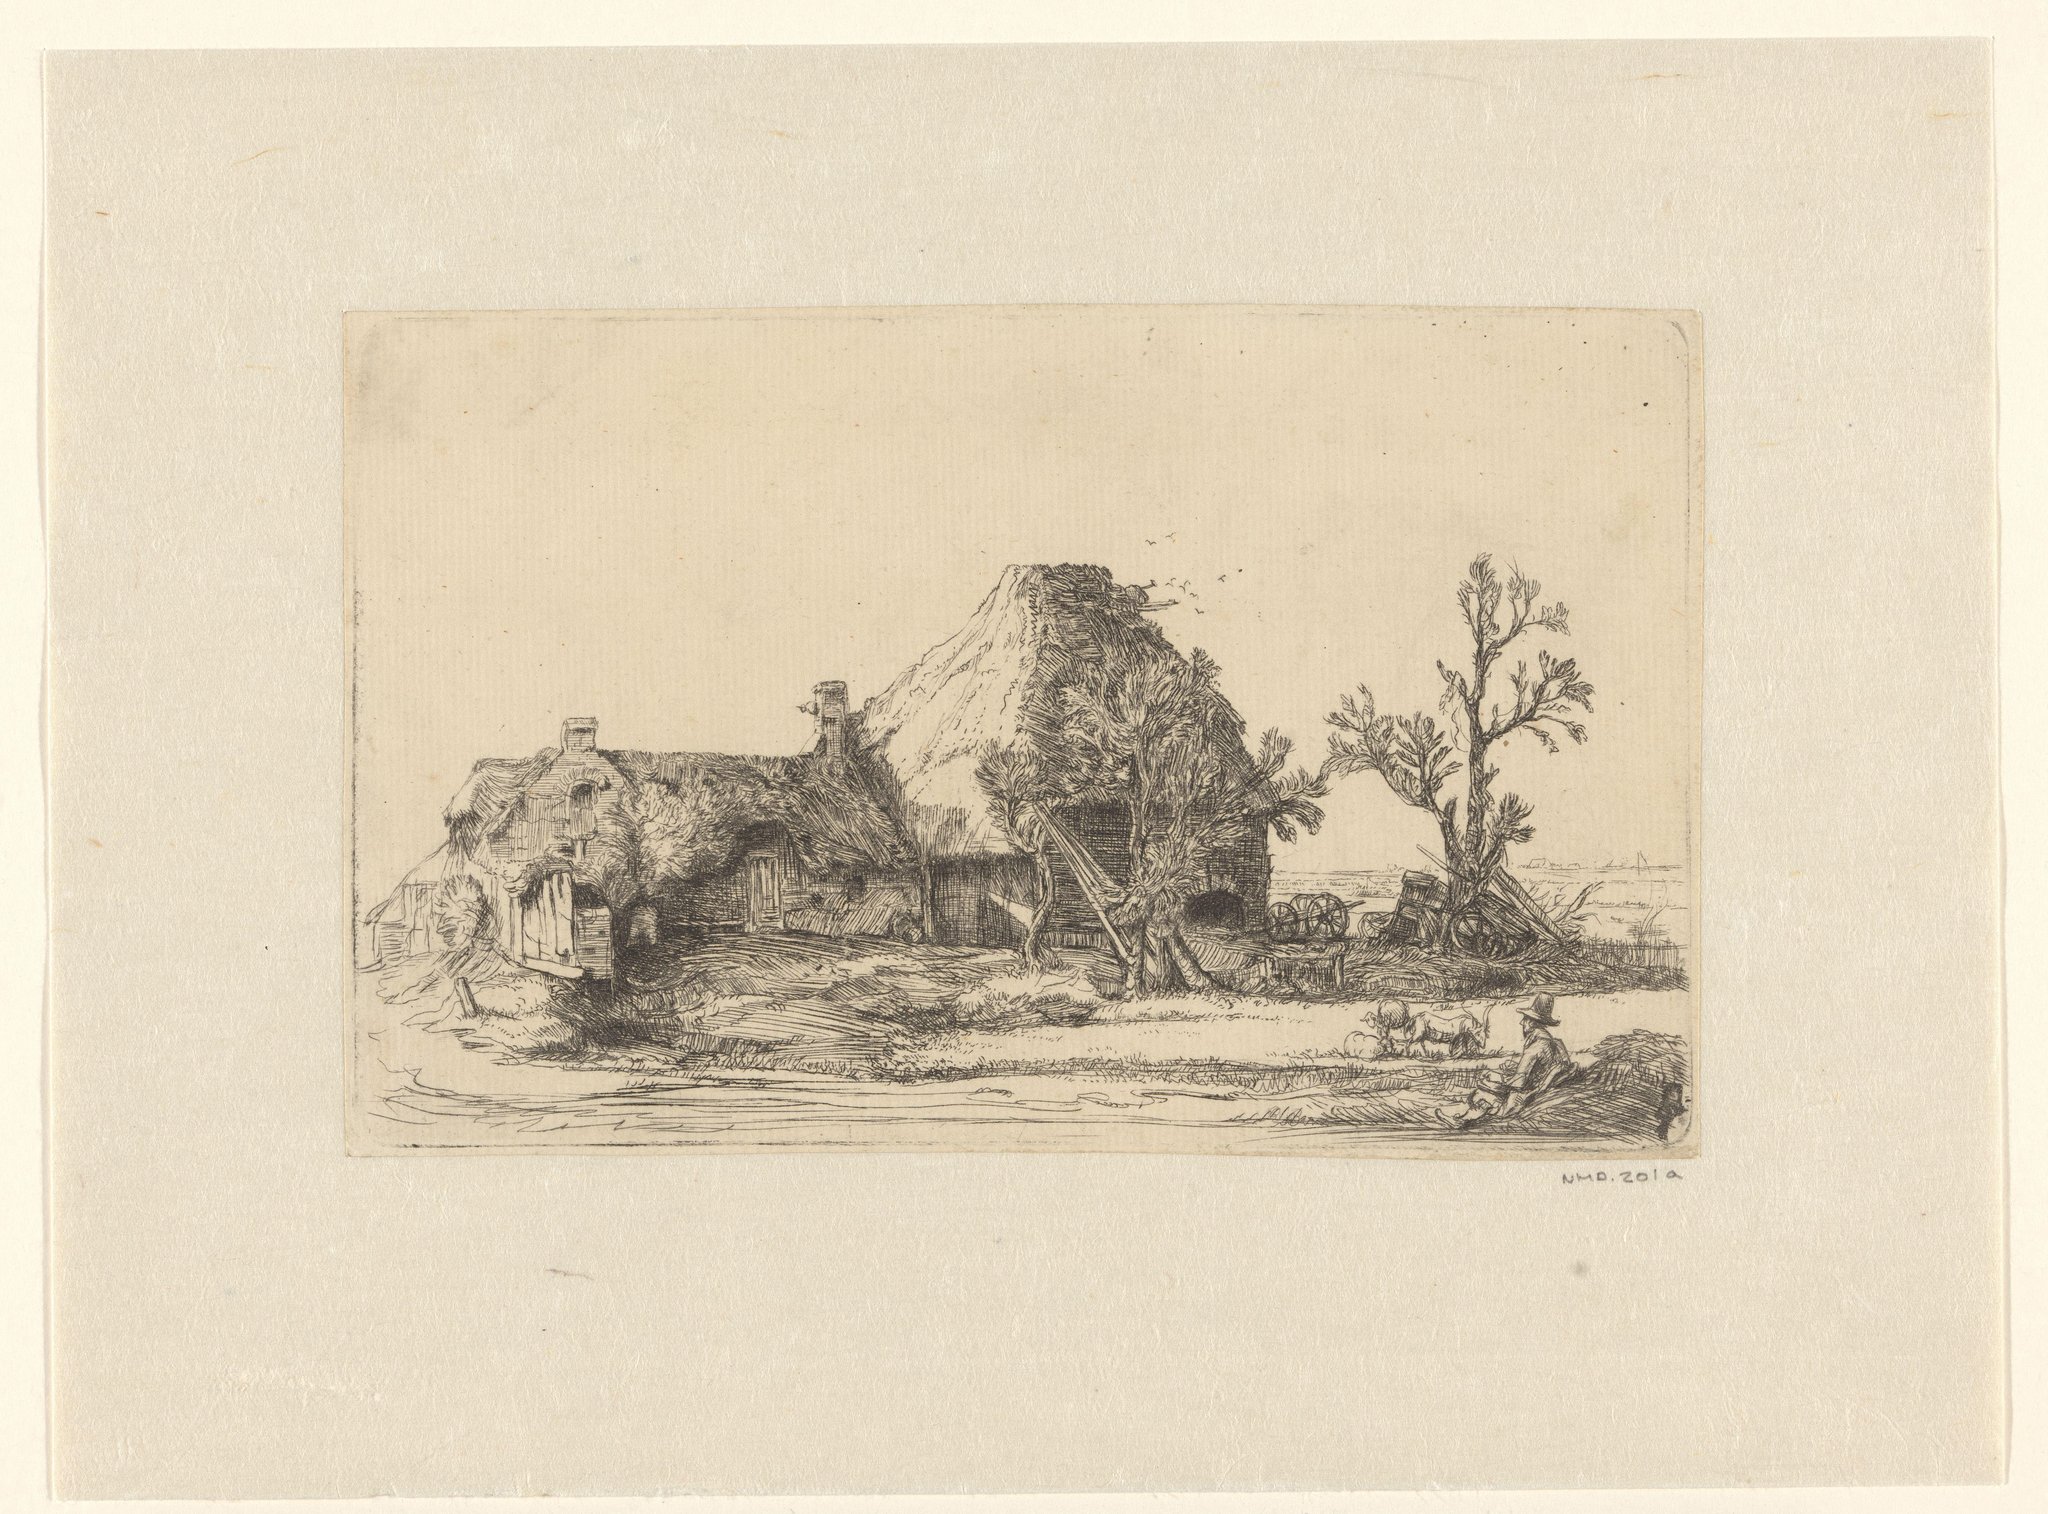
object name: print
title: Cottages and farm buildings with a man sketching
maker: richard byron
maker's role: print maker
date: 1750-1799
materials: paper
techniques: etching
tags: draughtsman at work - cc - out of doors, farm or solitary house in landscape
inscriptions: collector's mark: Lugt 2760, collector's mark: Lugt 2228